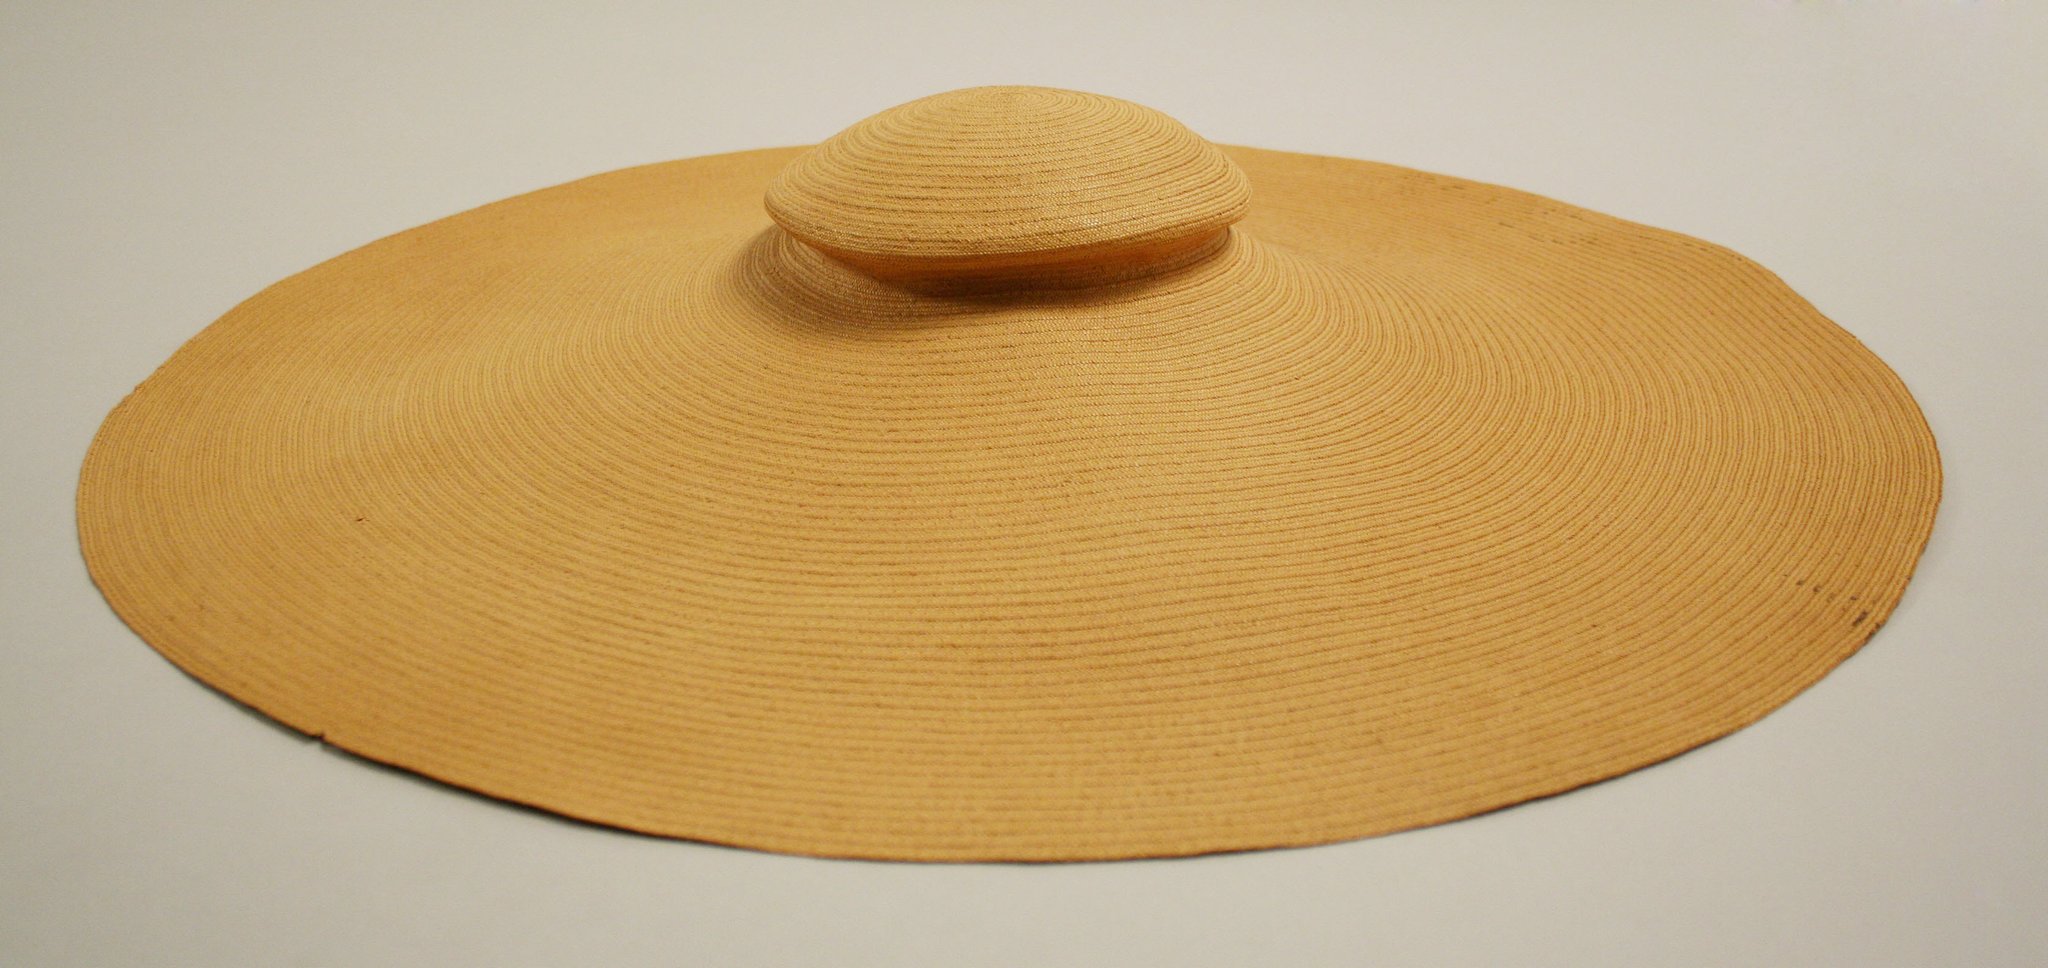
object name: hat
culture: american or european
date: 1801-1833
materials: fiber